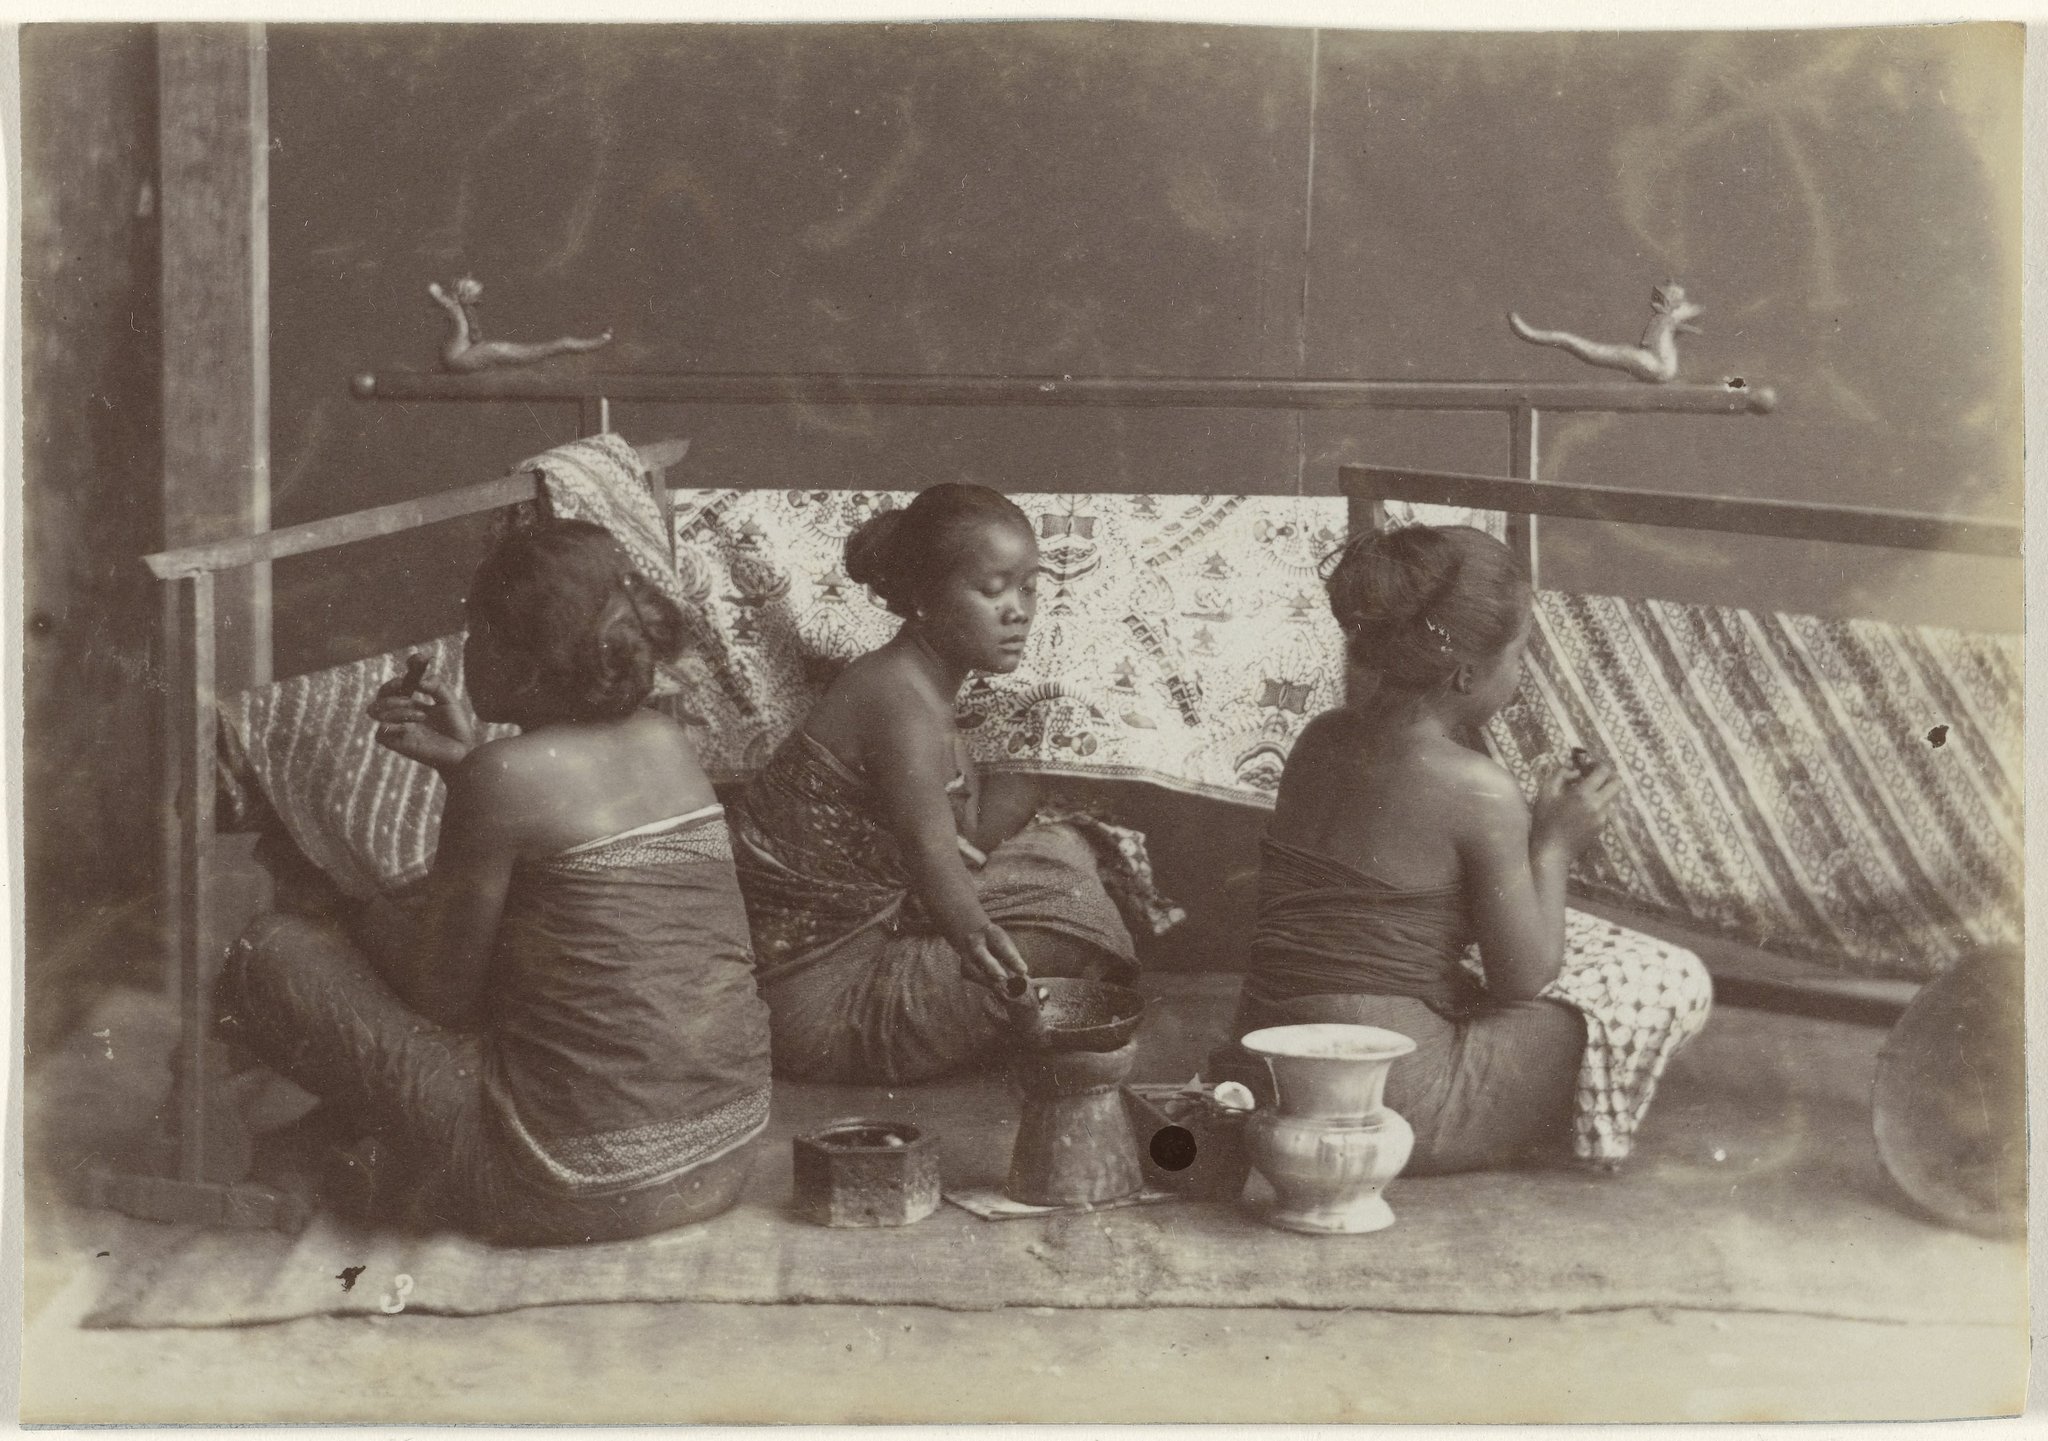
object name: photograph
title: Vrouwen batikken stof op Java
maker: Anonymous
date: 1870-1890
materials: paper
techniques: albumen print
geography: java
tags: dyeing of cloth with pattern; batik-work, java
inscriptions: number: ‘3’, inscription: ‘Typen van/ Java’